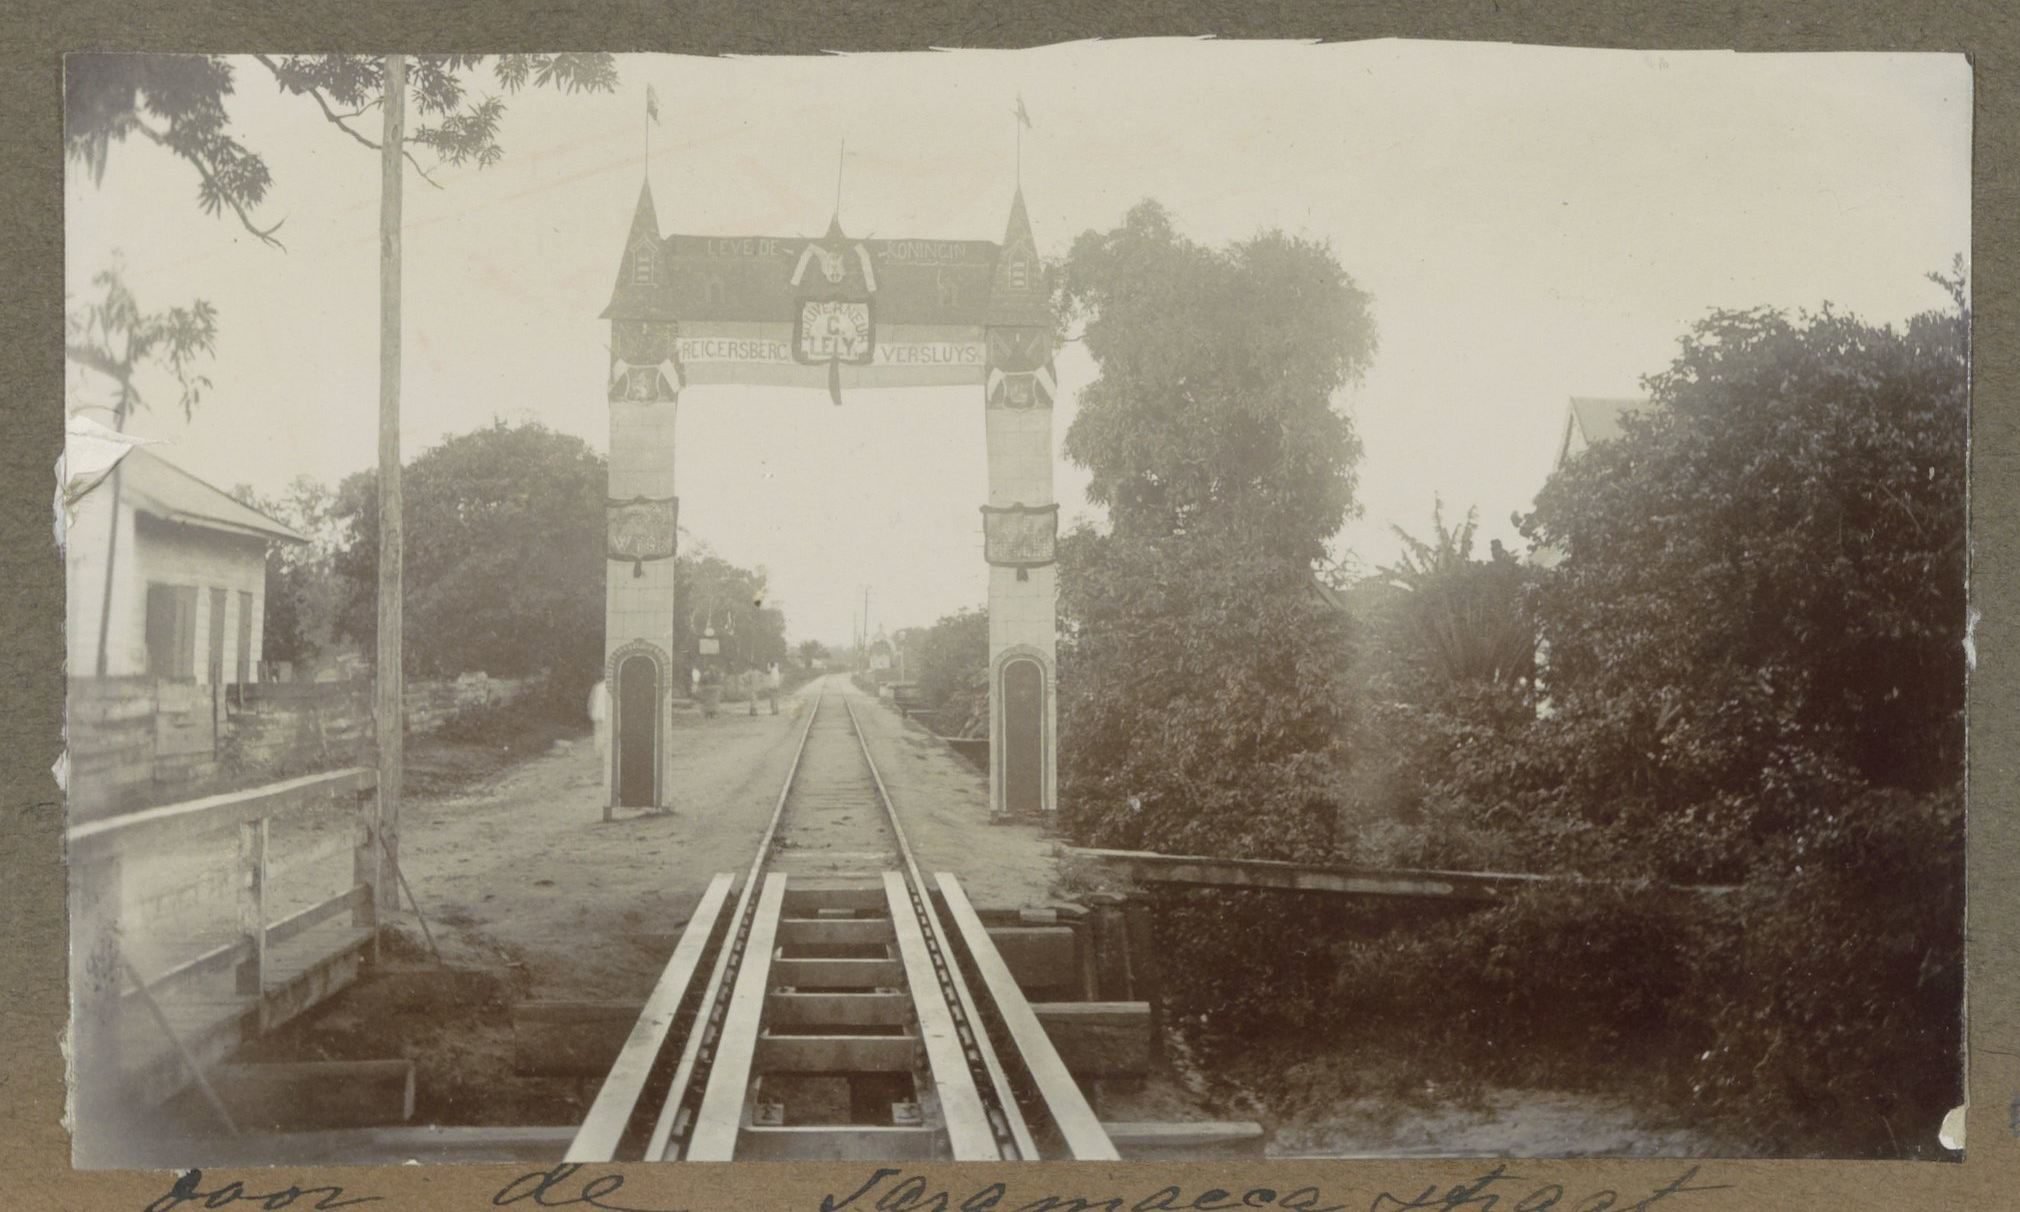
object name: photograph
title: Erepoort in de Saramaccastraat te Paramaribo, opgericht ter gelegenheid van de opening van de Lawaspoorlijn (Landsspoorweg) op 28 maart 1905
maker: eugen klein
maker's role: fotograaf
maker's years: 1869-1927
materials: photographic support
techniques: gelatin silver print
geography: suriname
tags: gate, entrance, railway, train, festivities on events of national importance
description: Onderdeel van fotoalbum van een onbekende Nederlandse familie met opnames van Suriname, Europa en Nederlands-Indië.